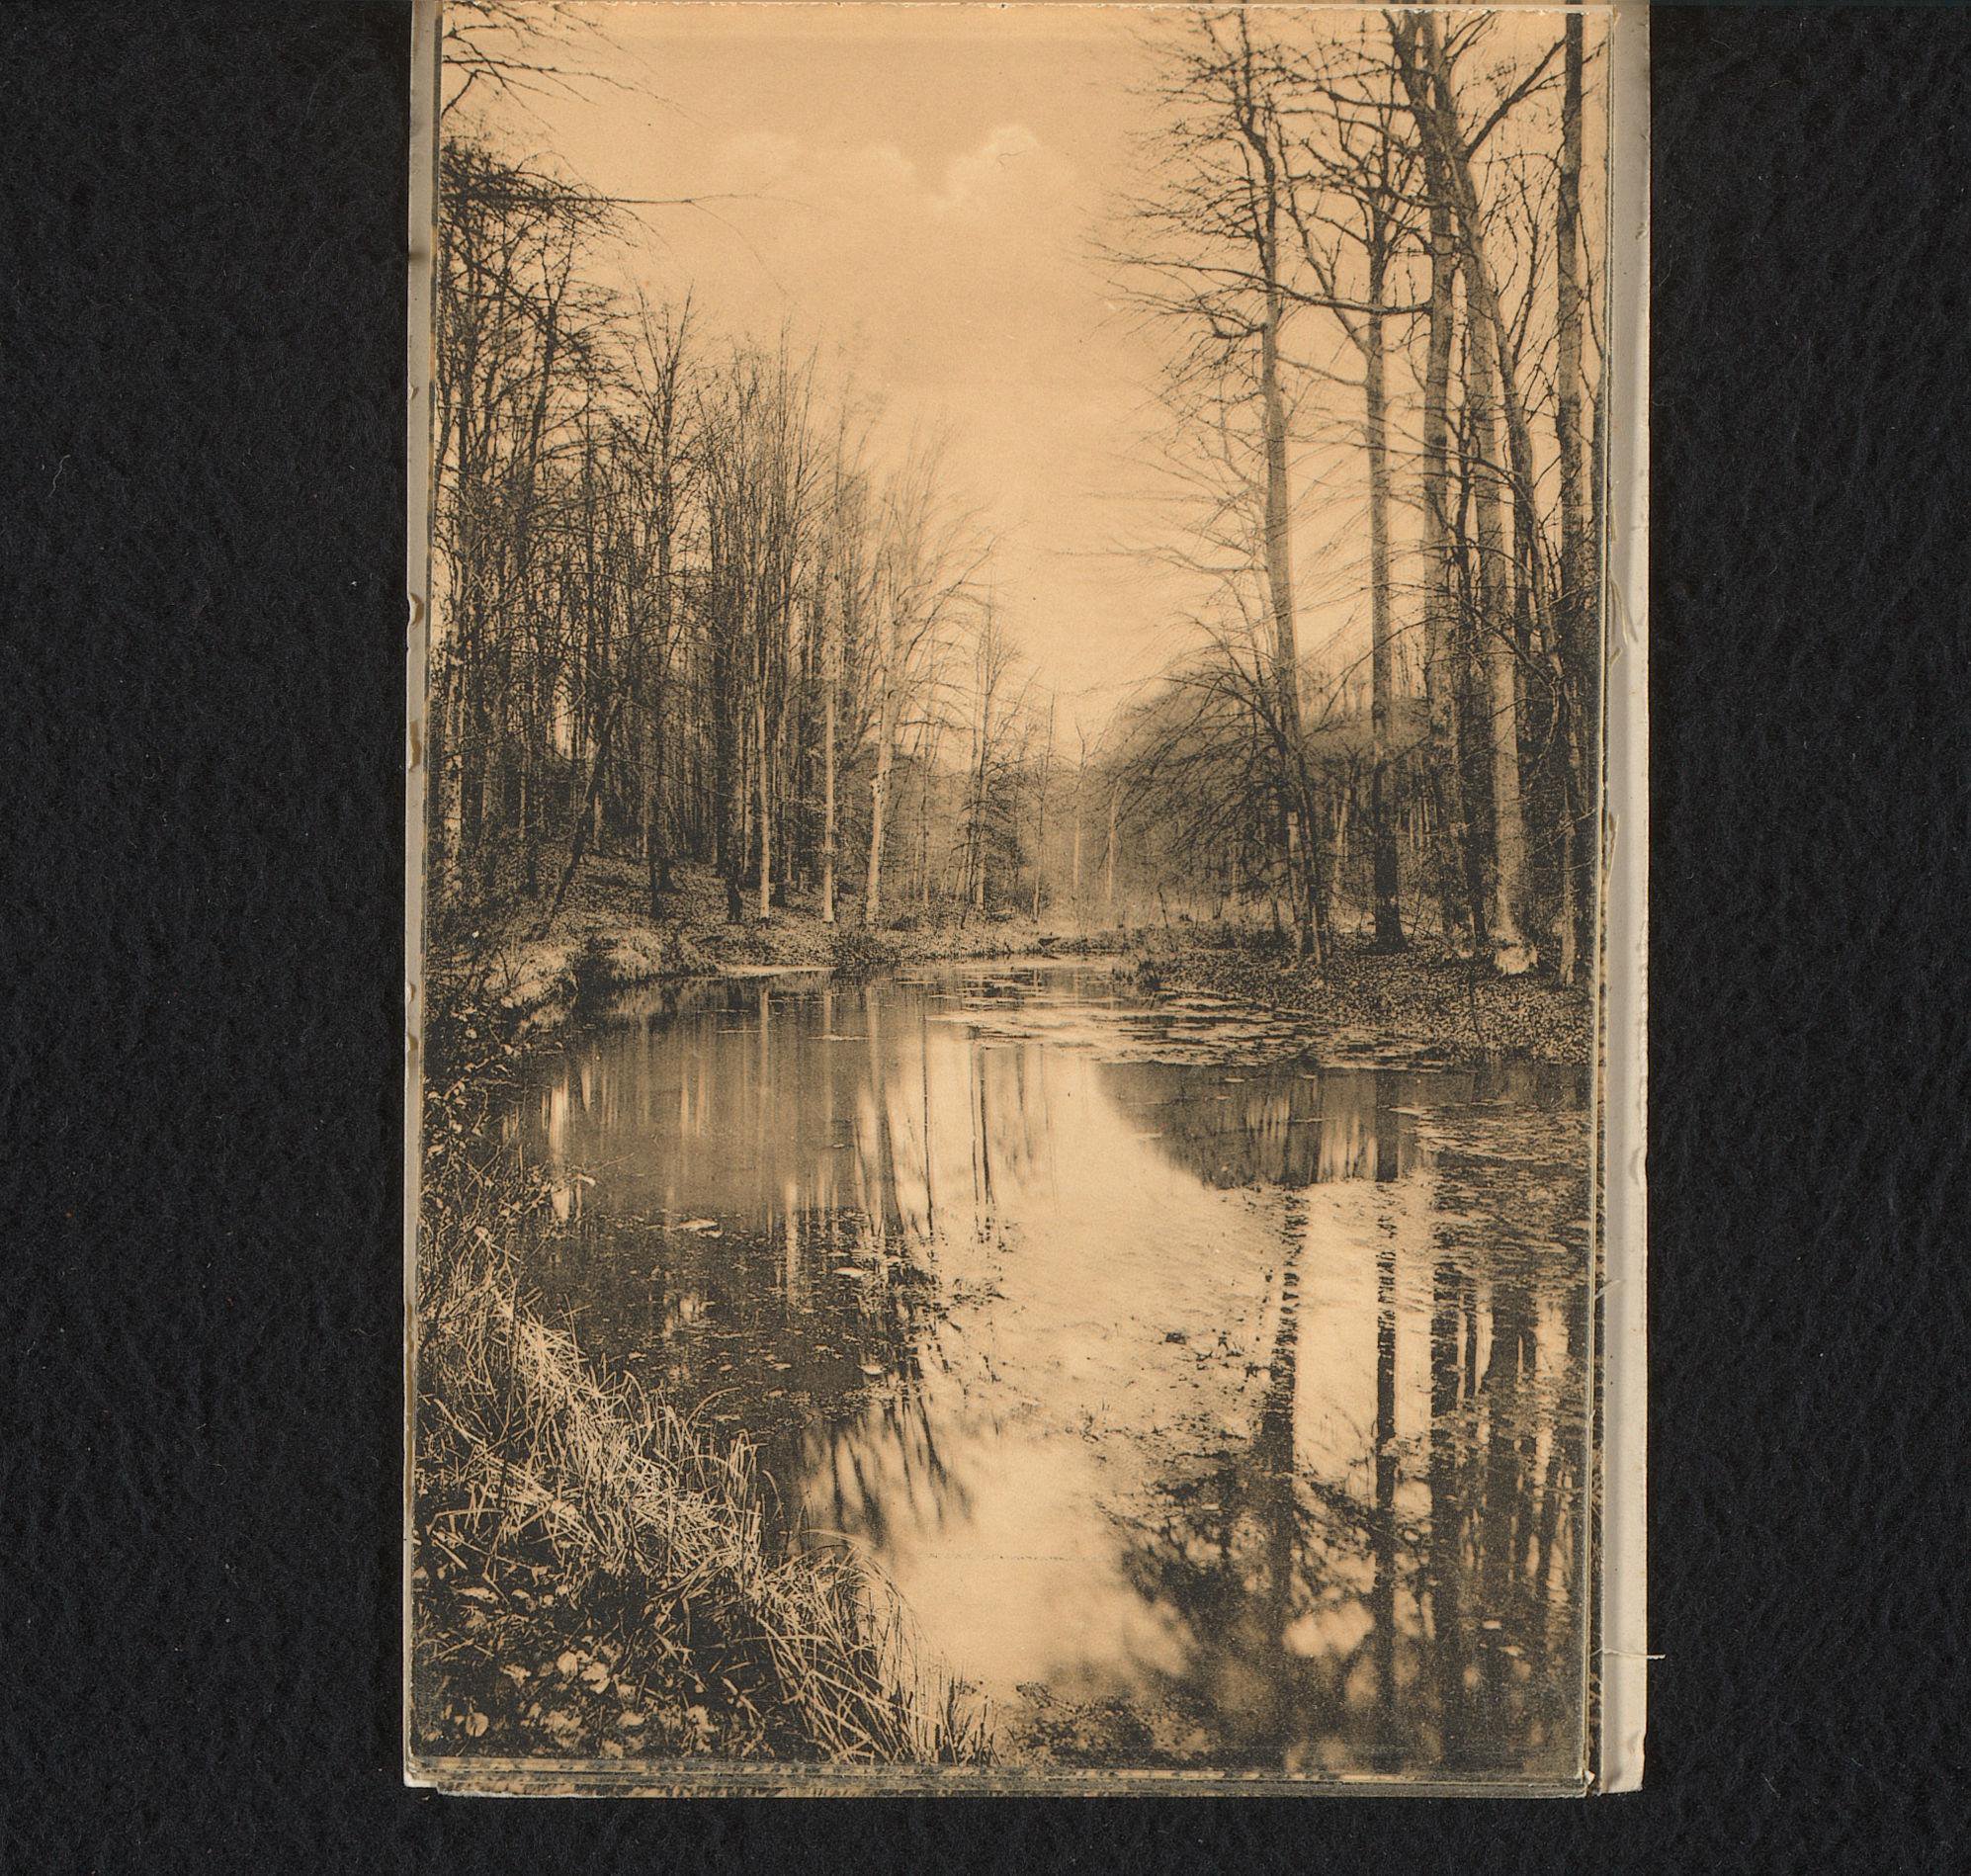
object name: ansichtkaart, prentbriefkaart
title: Etang de l'Ermite (vallon de la Vuylbeek)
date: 1909-1914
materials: cardboard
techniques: photograph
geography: zoniënwoud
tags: forest, wood, pond, pool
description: Prentbriefkaart maakt deel uit van een album.